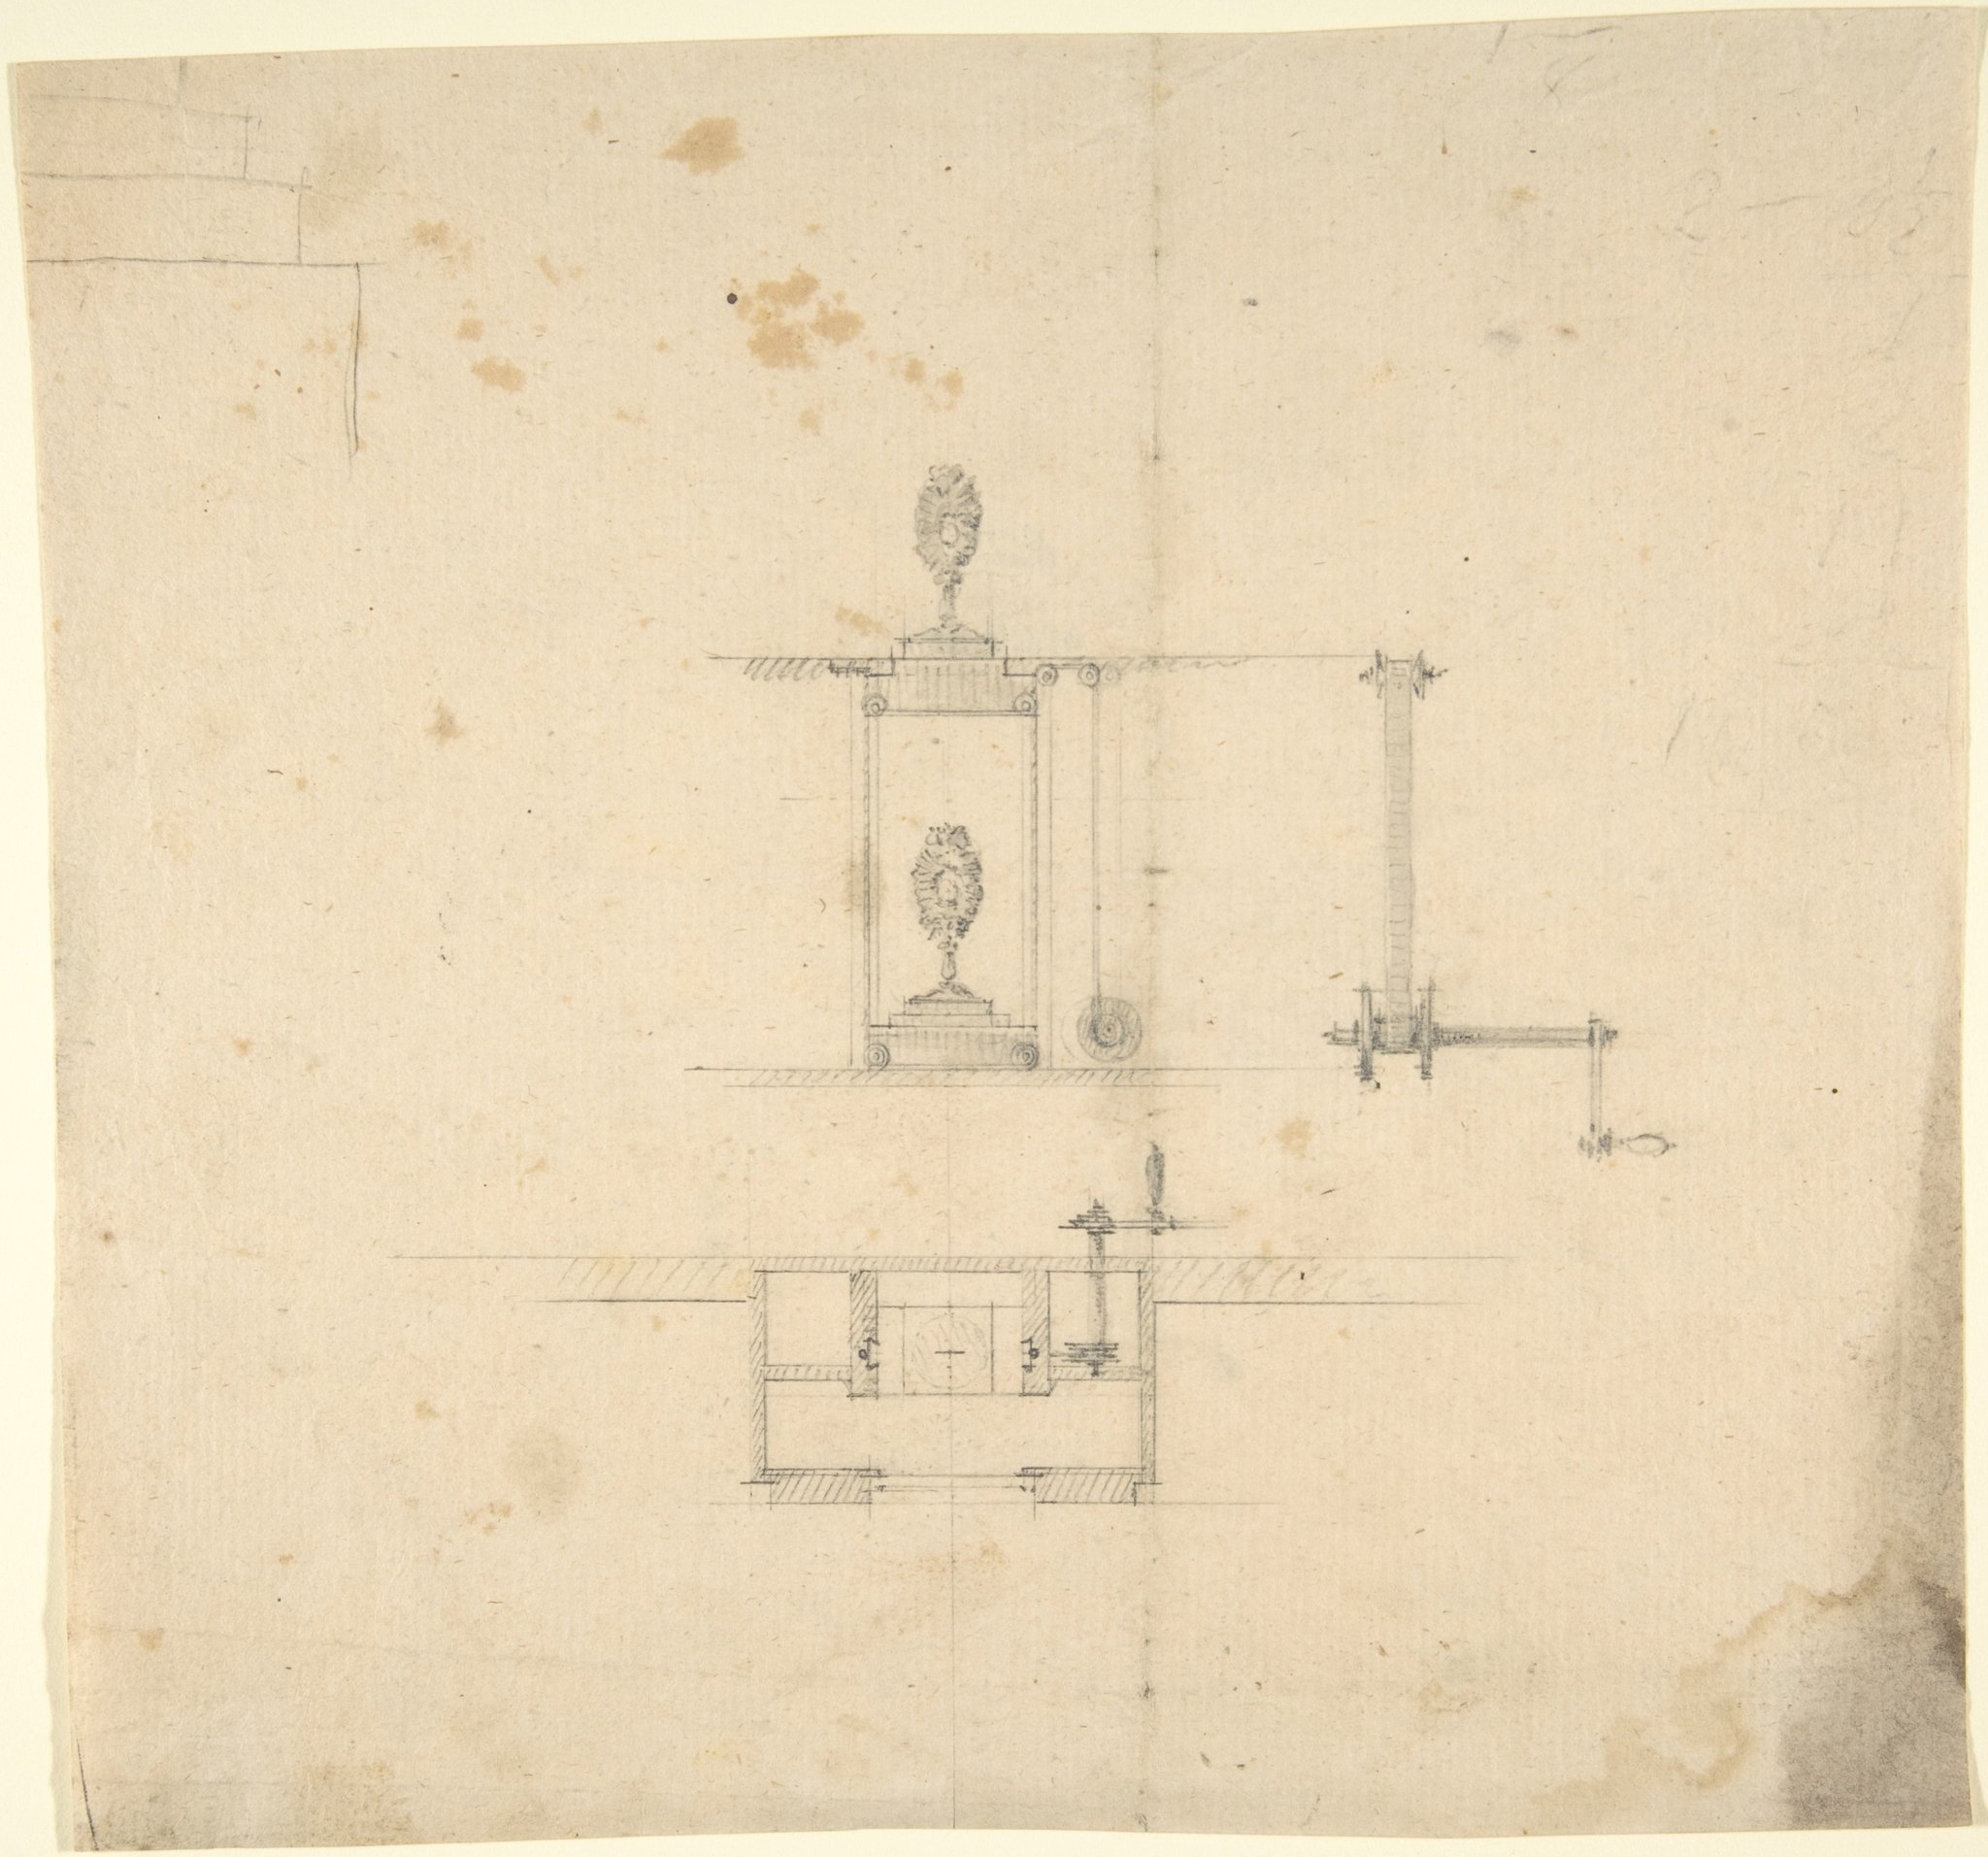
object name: drawing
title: Design for a Machine to Raise and Lower Machinery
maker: anonymous, german, 19th century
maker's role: artist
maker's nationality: german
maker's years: 1800-1899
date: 1801-1900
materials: graphite